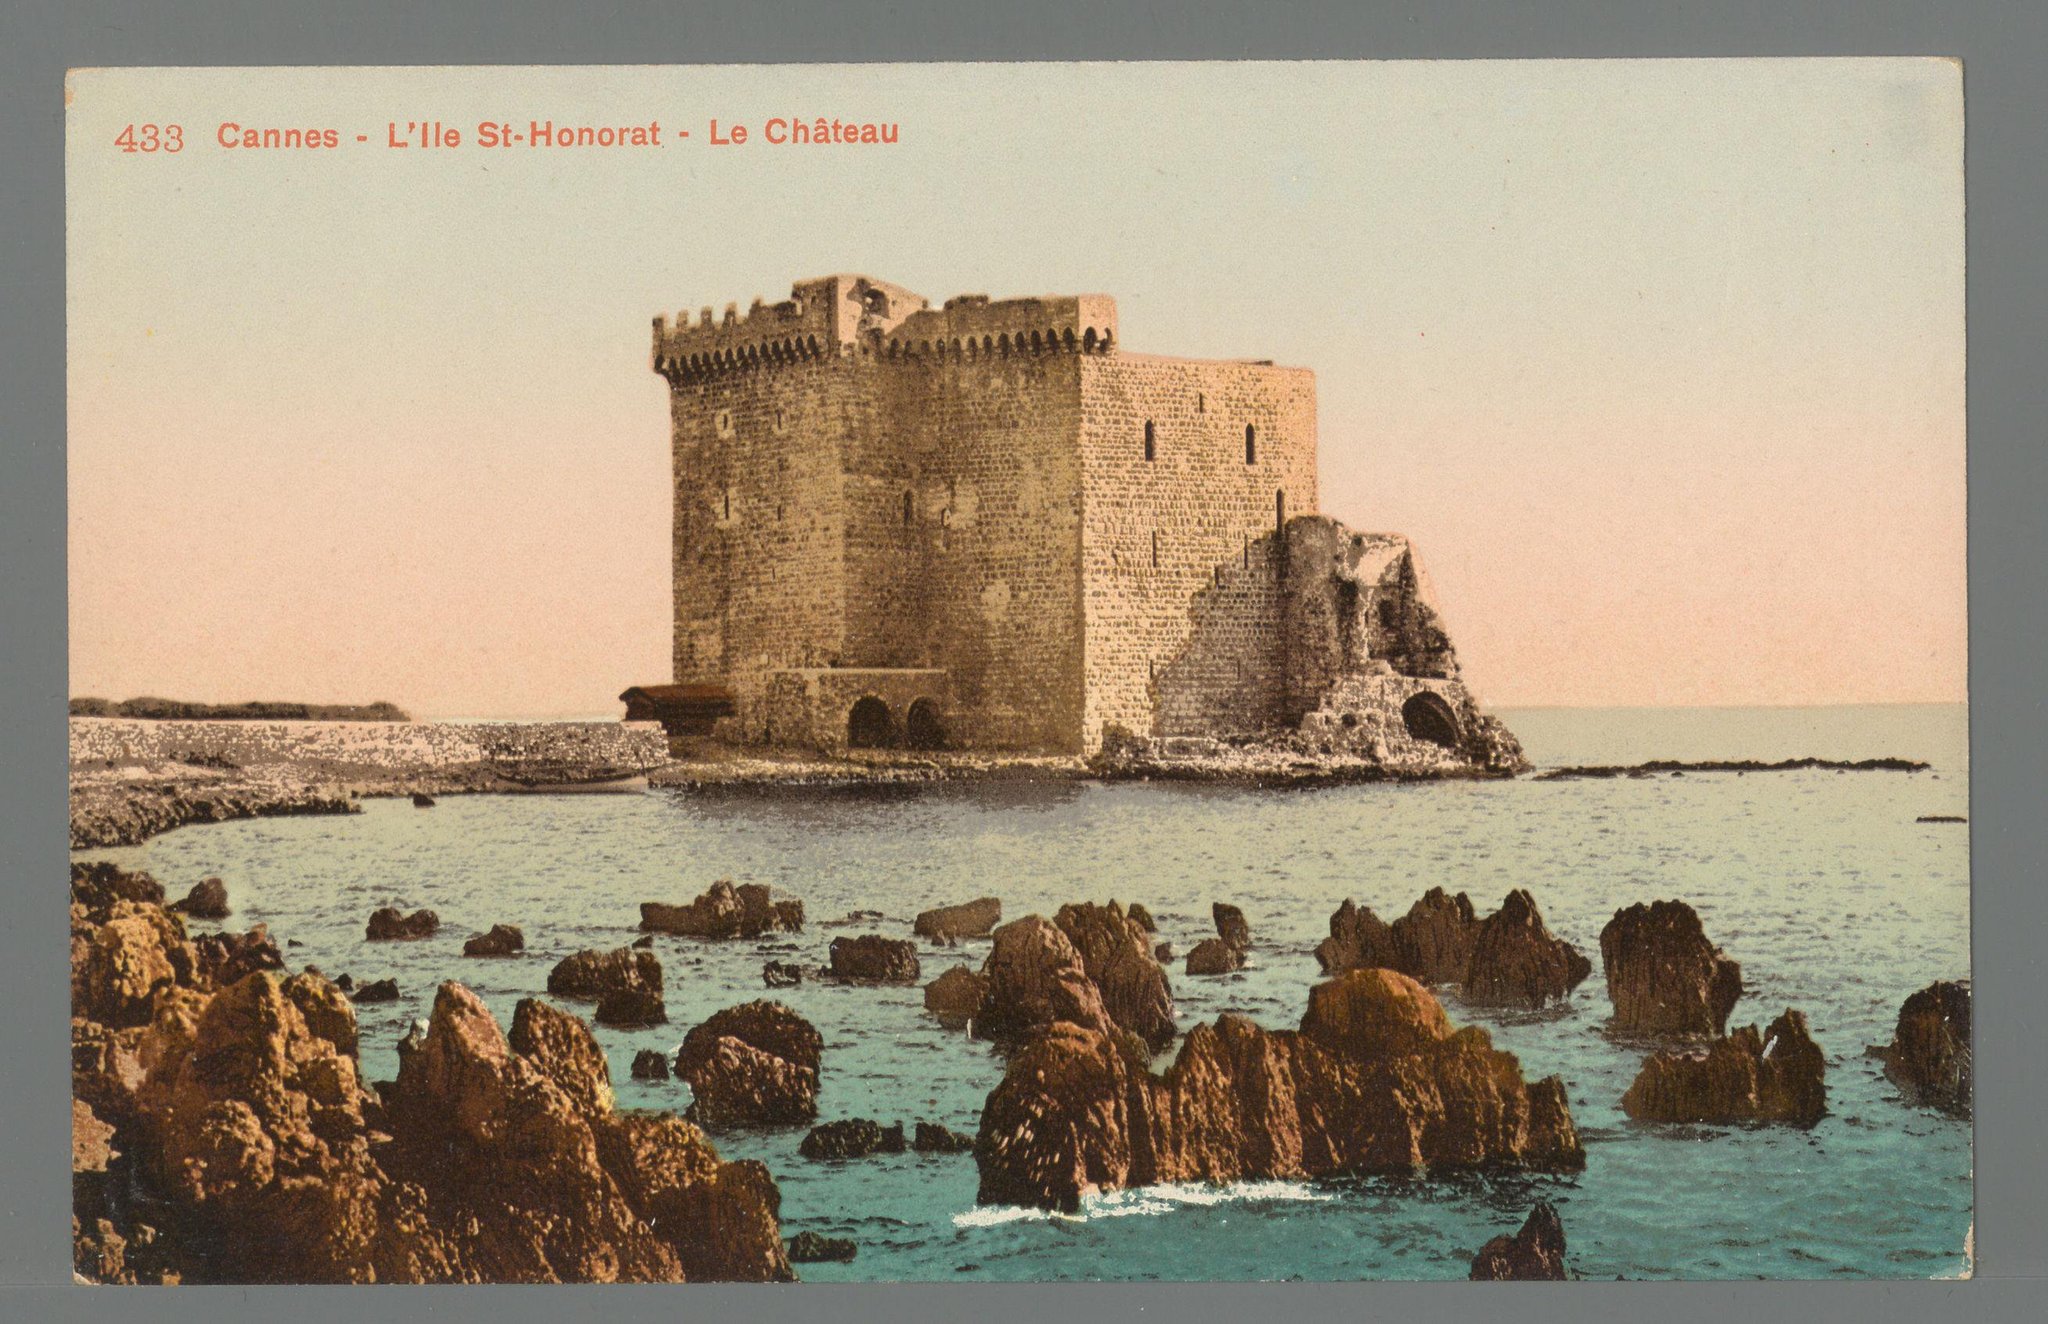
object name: ansichtkaart, prentbriefkaart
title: Cannes. L'Ile St. Honorat. Le Château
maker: Anonymous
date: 1903-1930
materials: cardboard, photographic process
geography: cannes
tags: castle, sea (seascape)